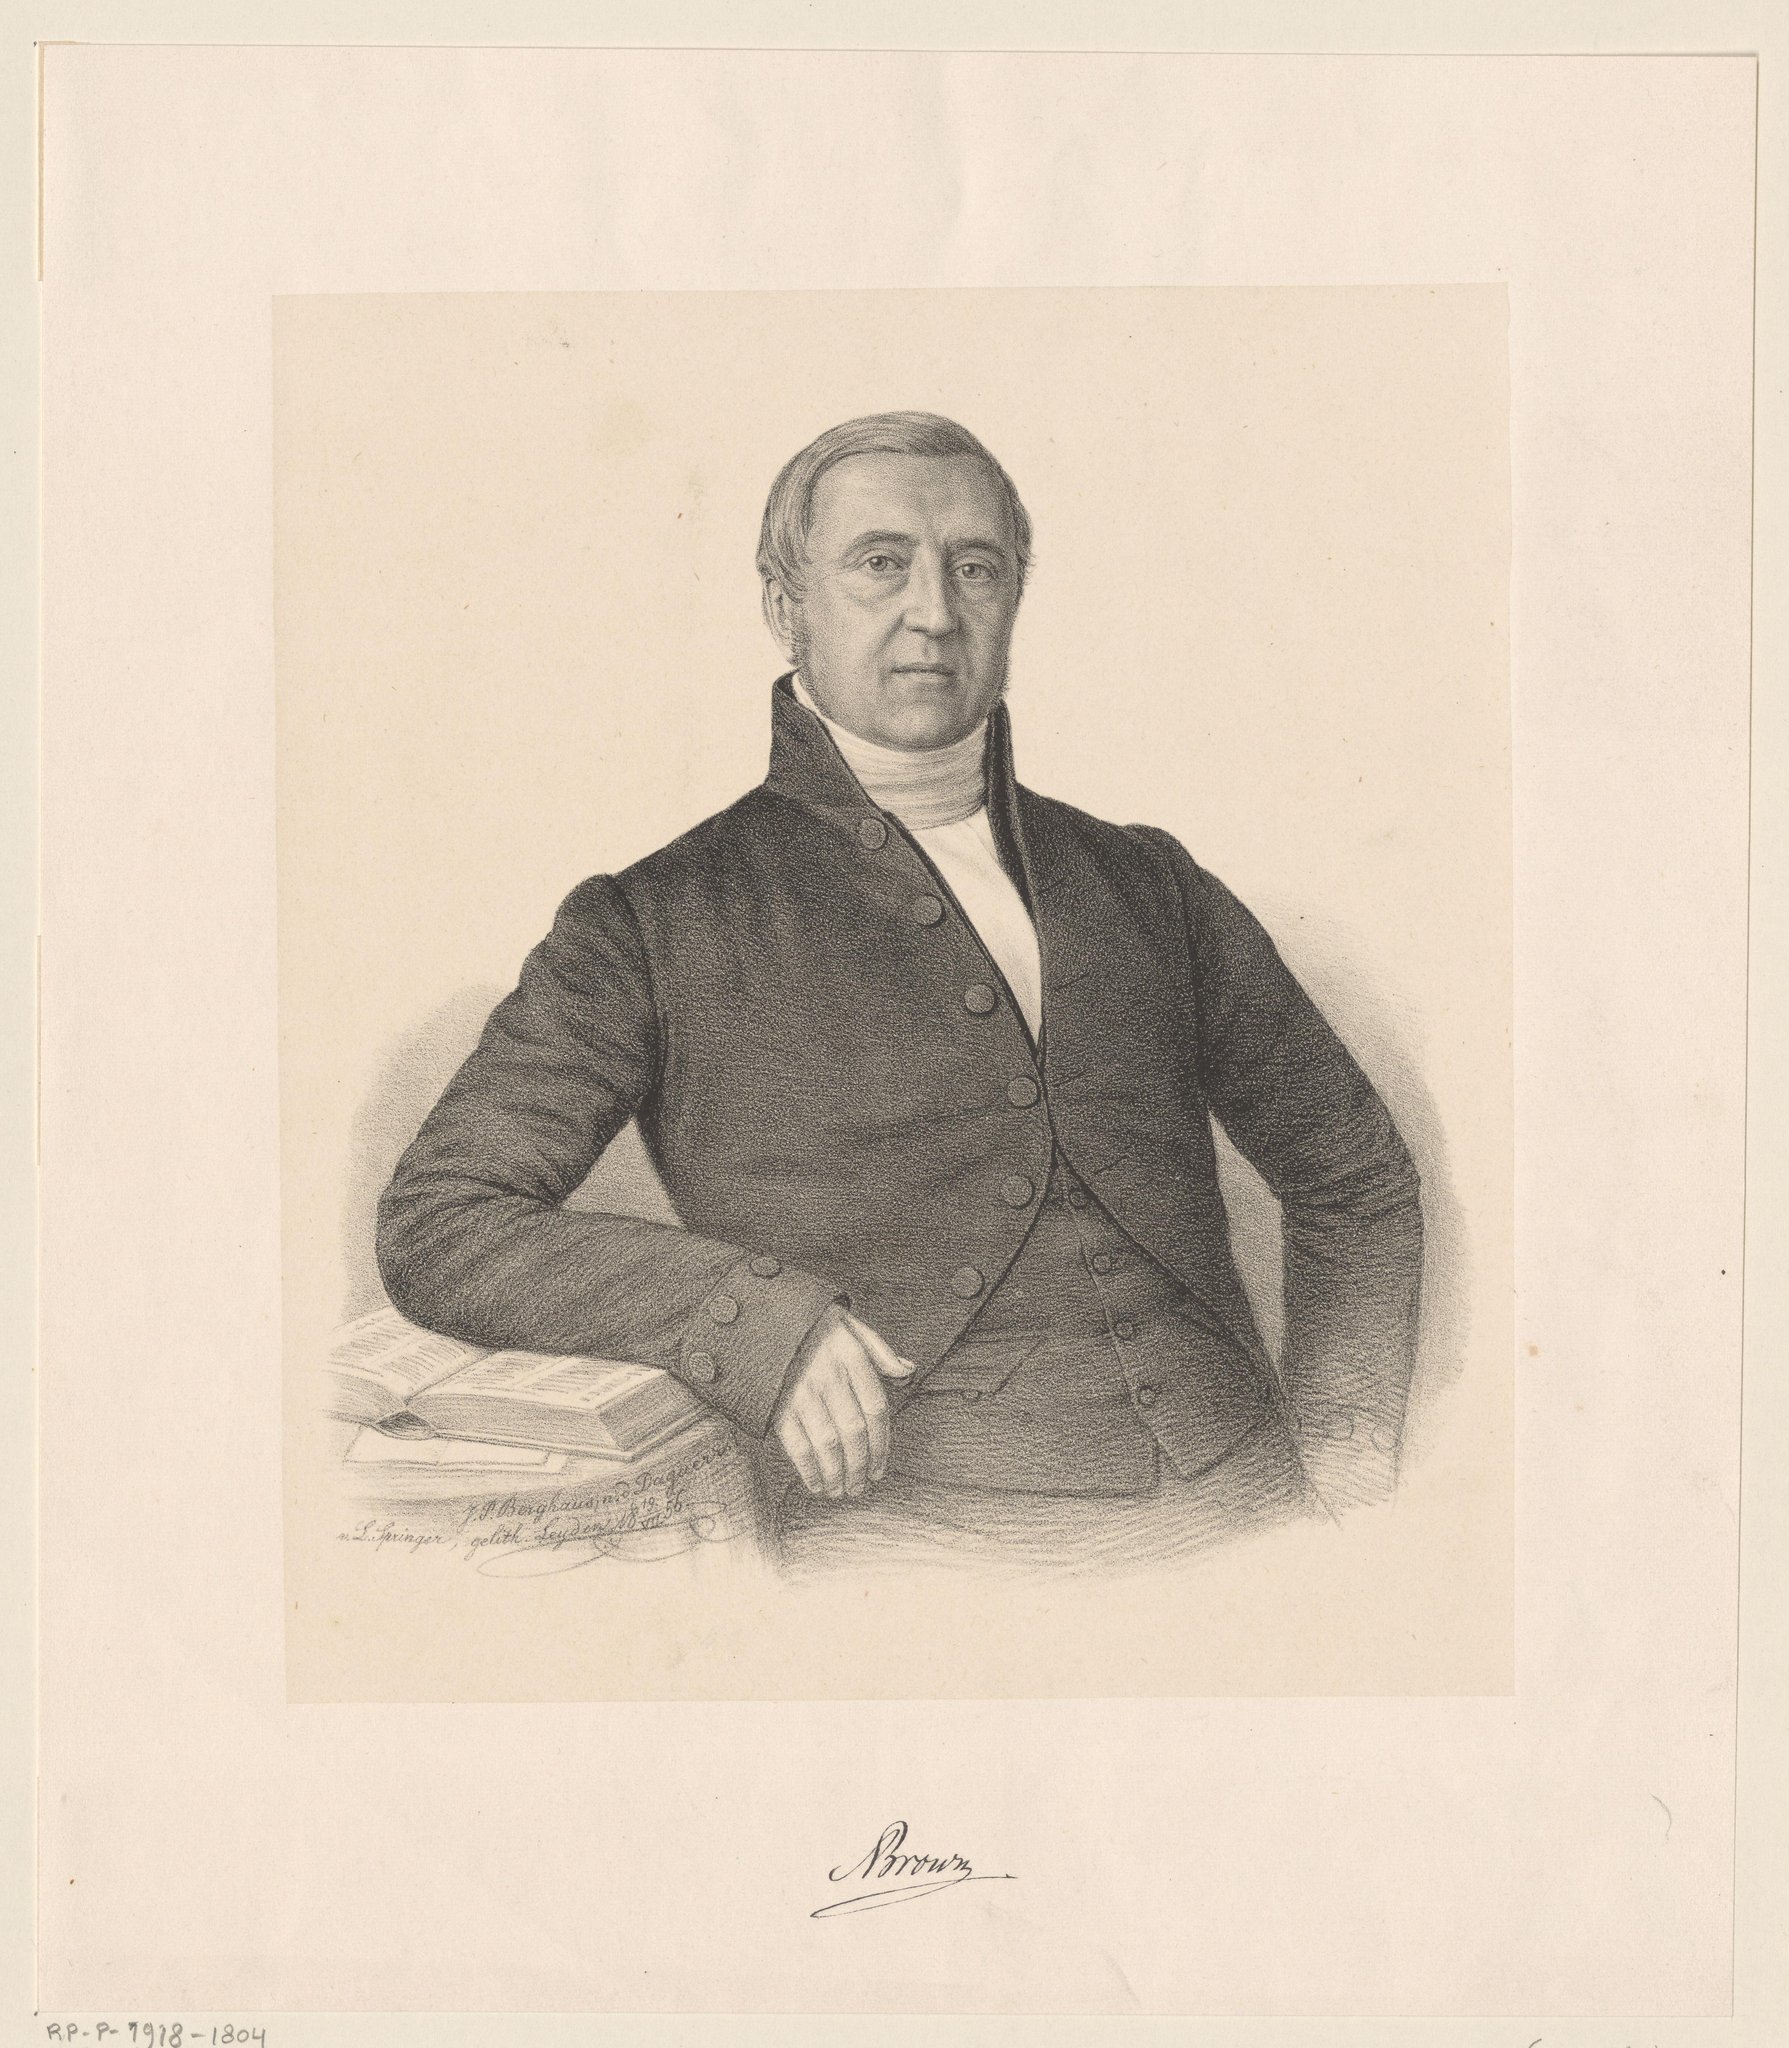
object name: print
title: Portret van Alef Brown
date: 1856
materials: paper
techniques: lithograph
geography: leiden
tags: arnhem, leiden, historical persons, book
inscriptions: collector's mark: Lugt 2233